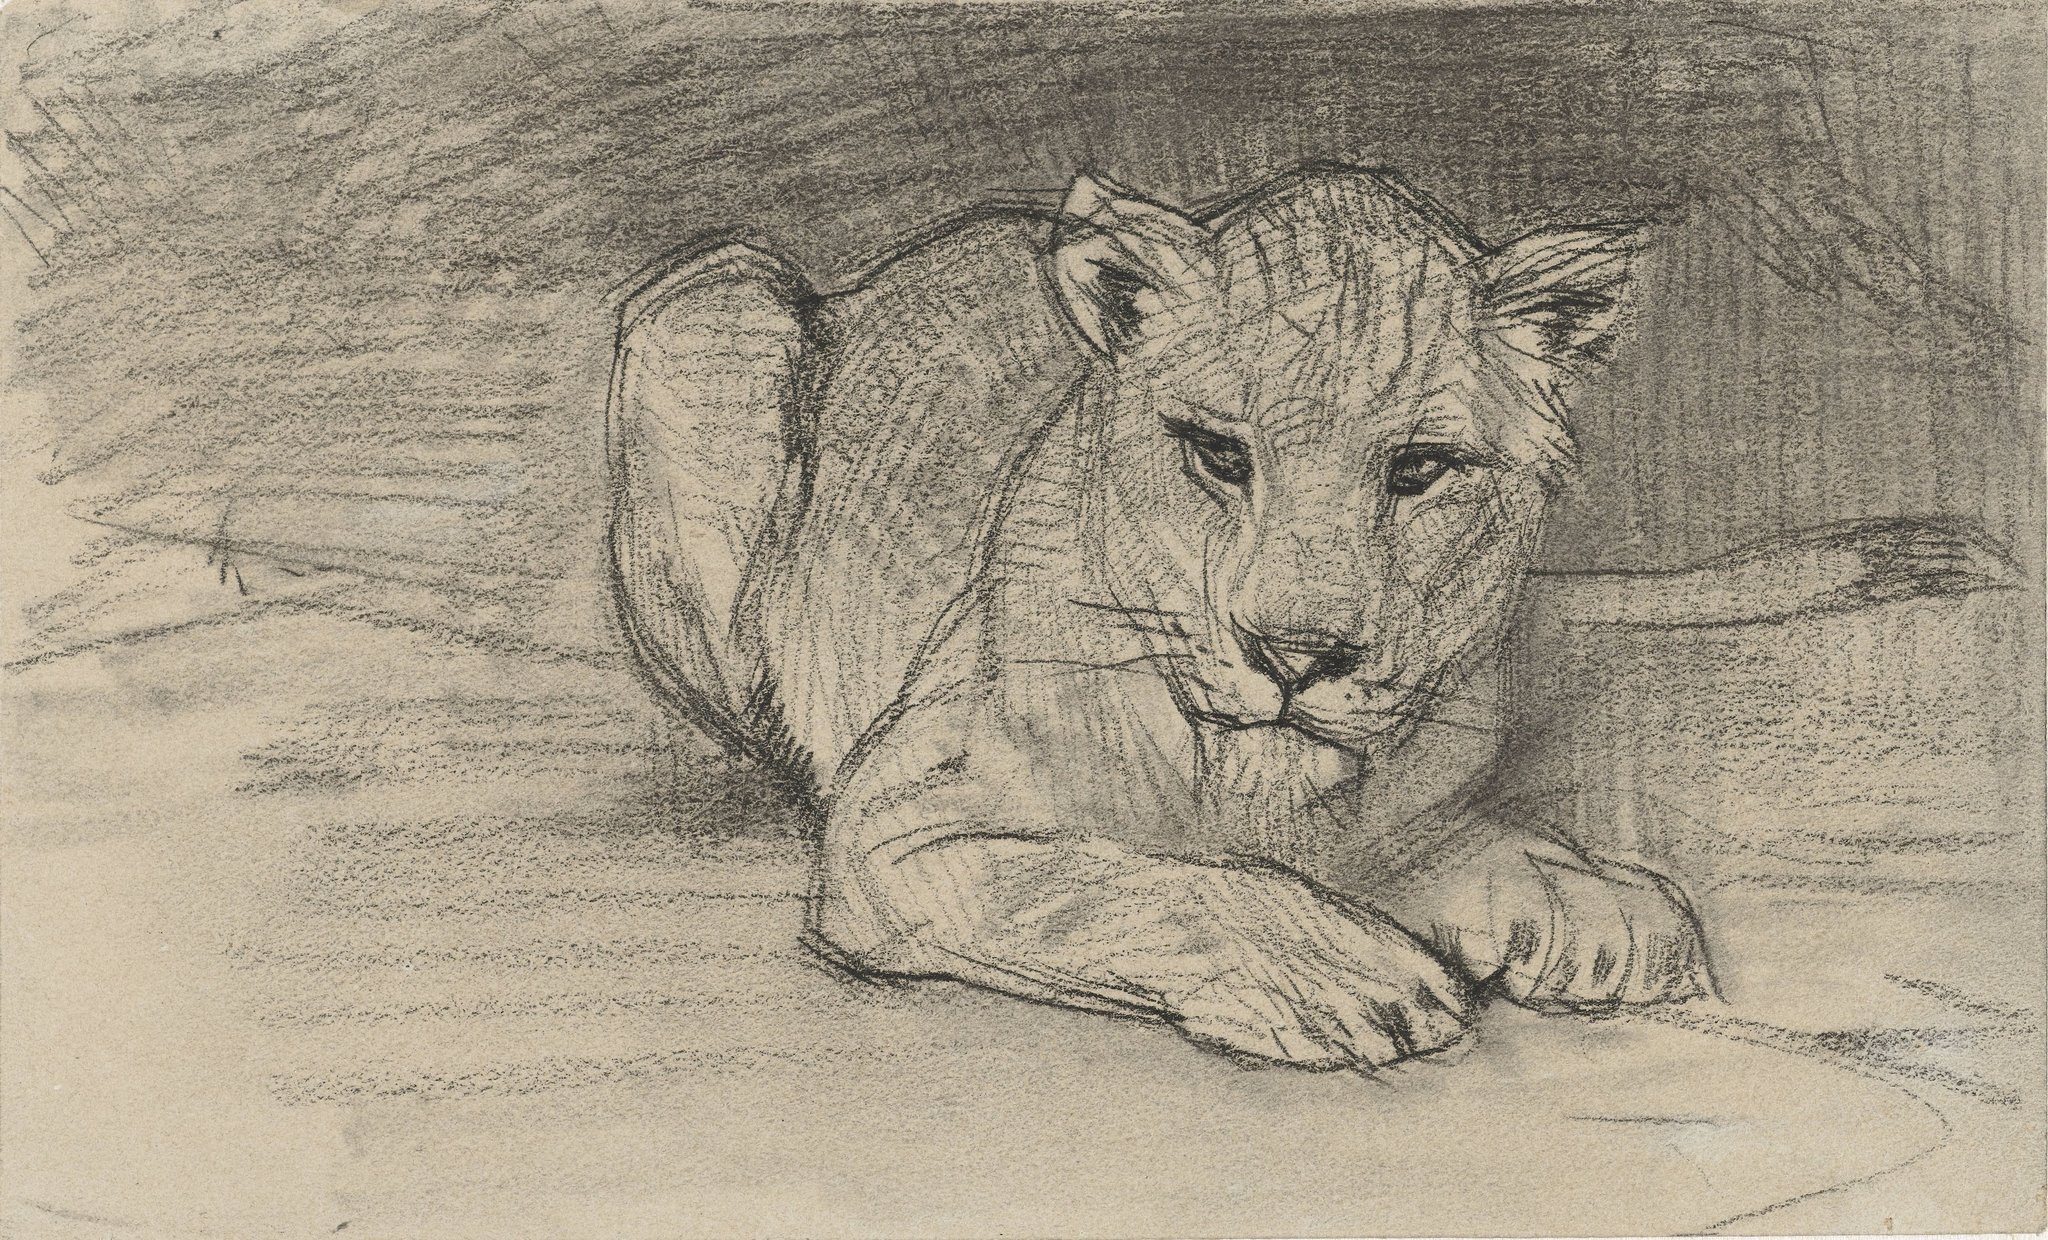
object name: drawing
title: Liggende leeuwin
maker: august allebé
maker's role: draughtsman, print maker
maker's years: 1838-1927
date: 1848-1884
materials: chalk, paper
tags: beasts of prey, predatory animals: lion